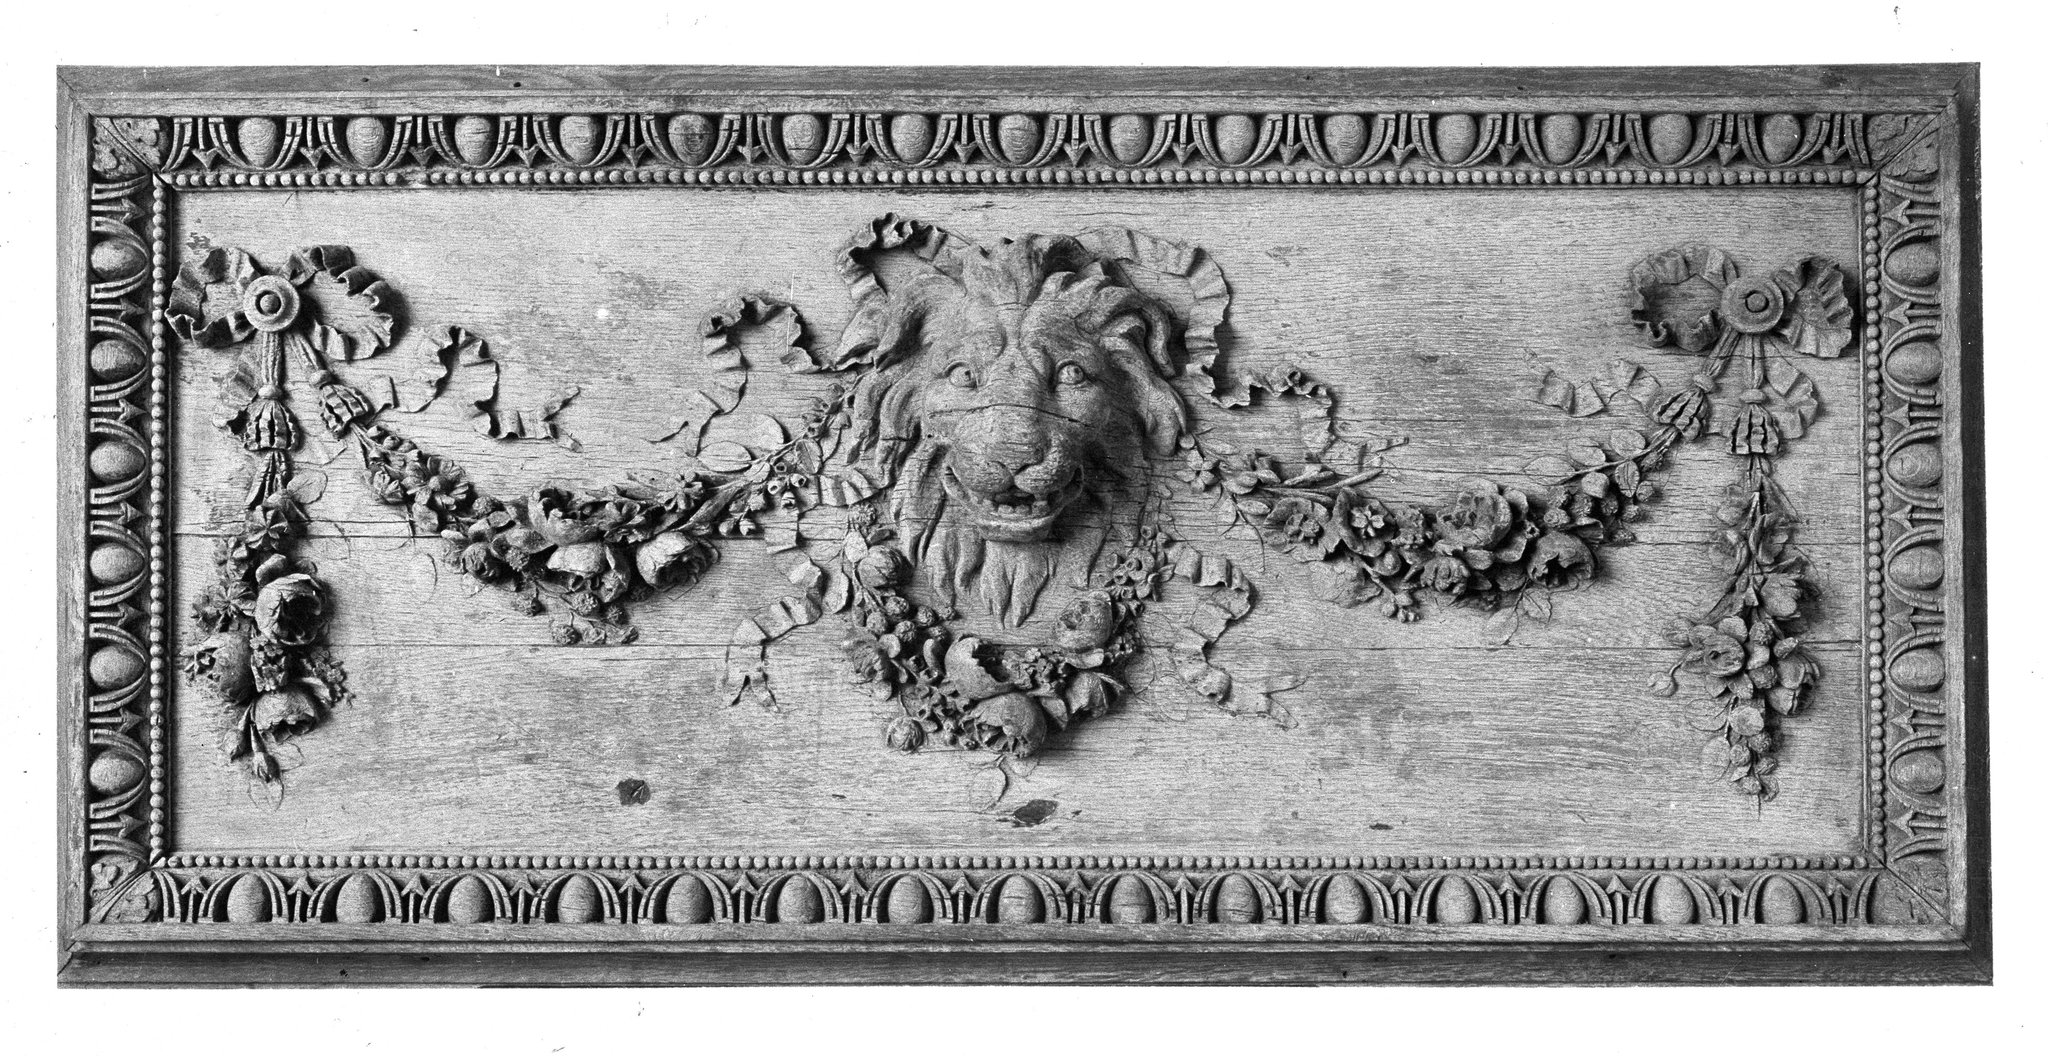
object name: panel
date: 1701-1800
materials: wood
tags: lions,flowers